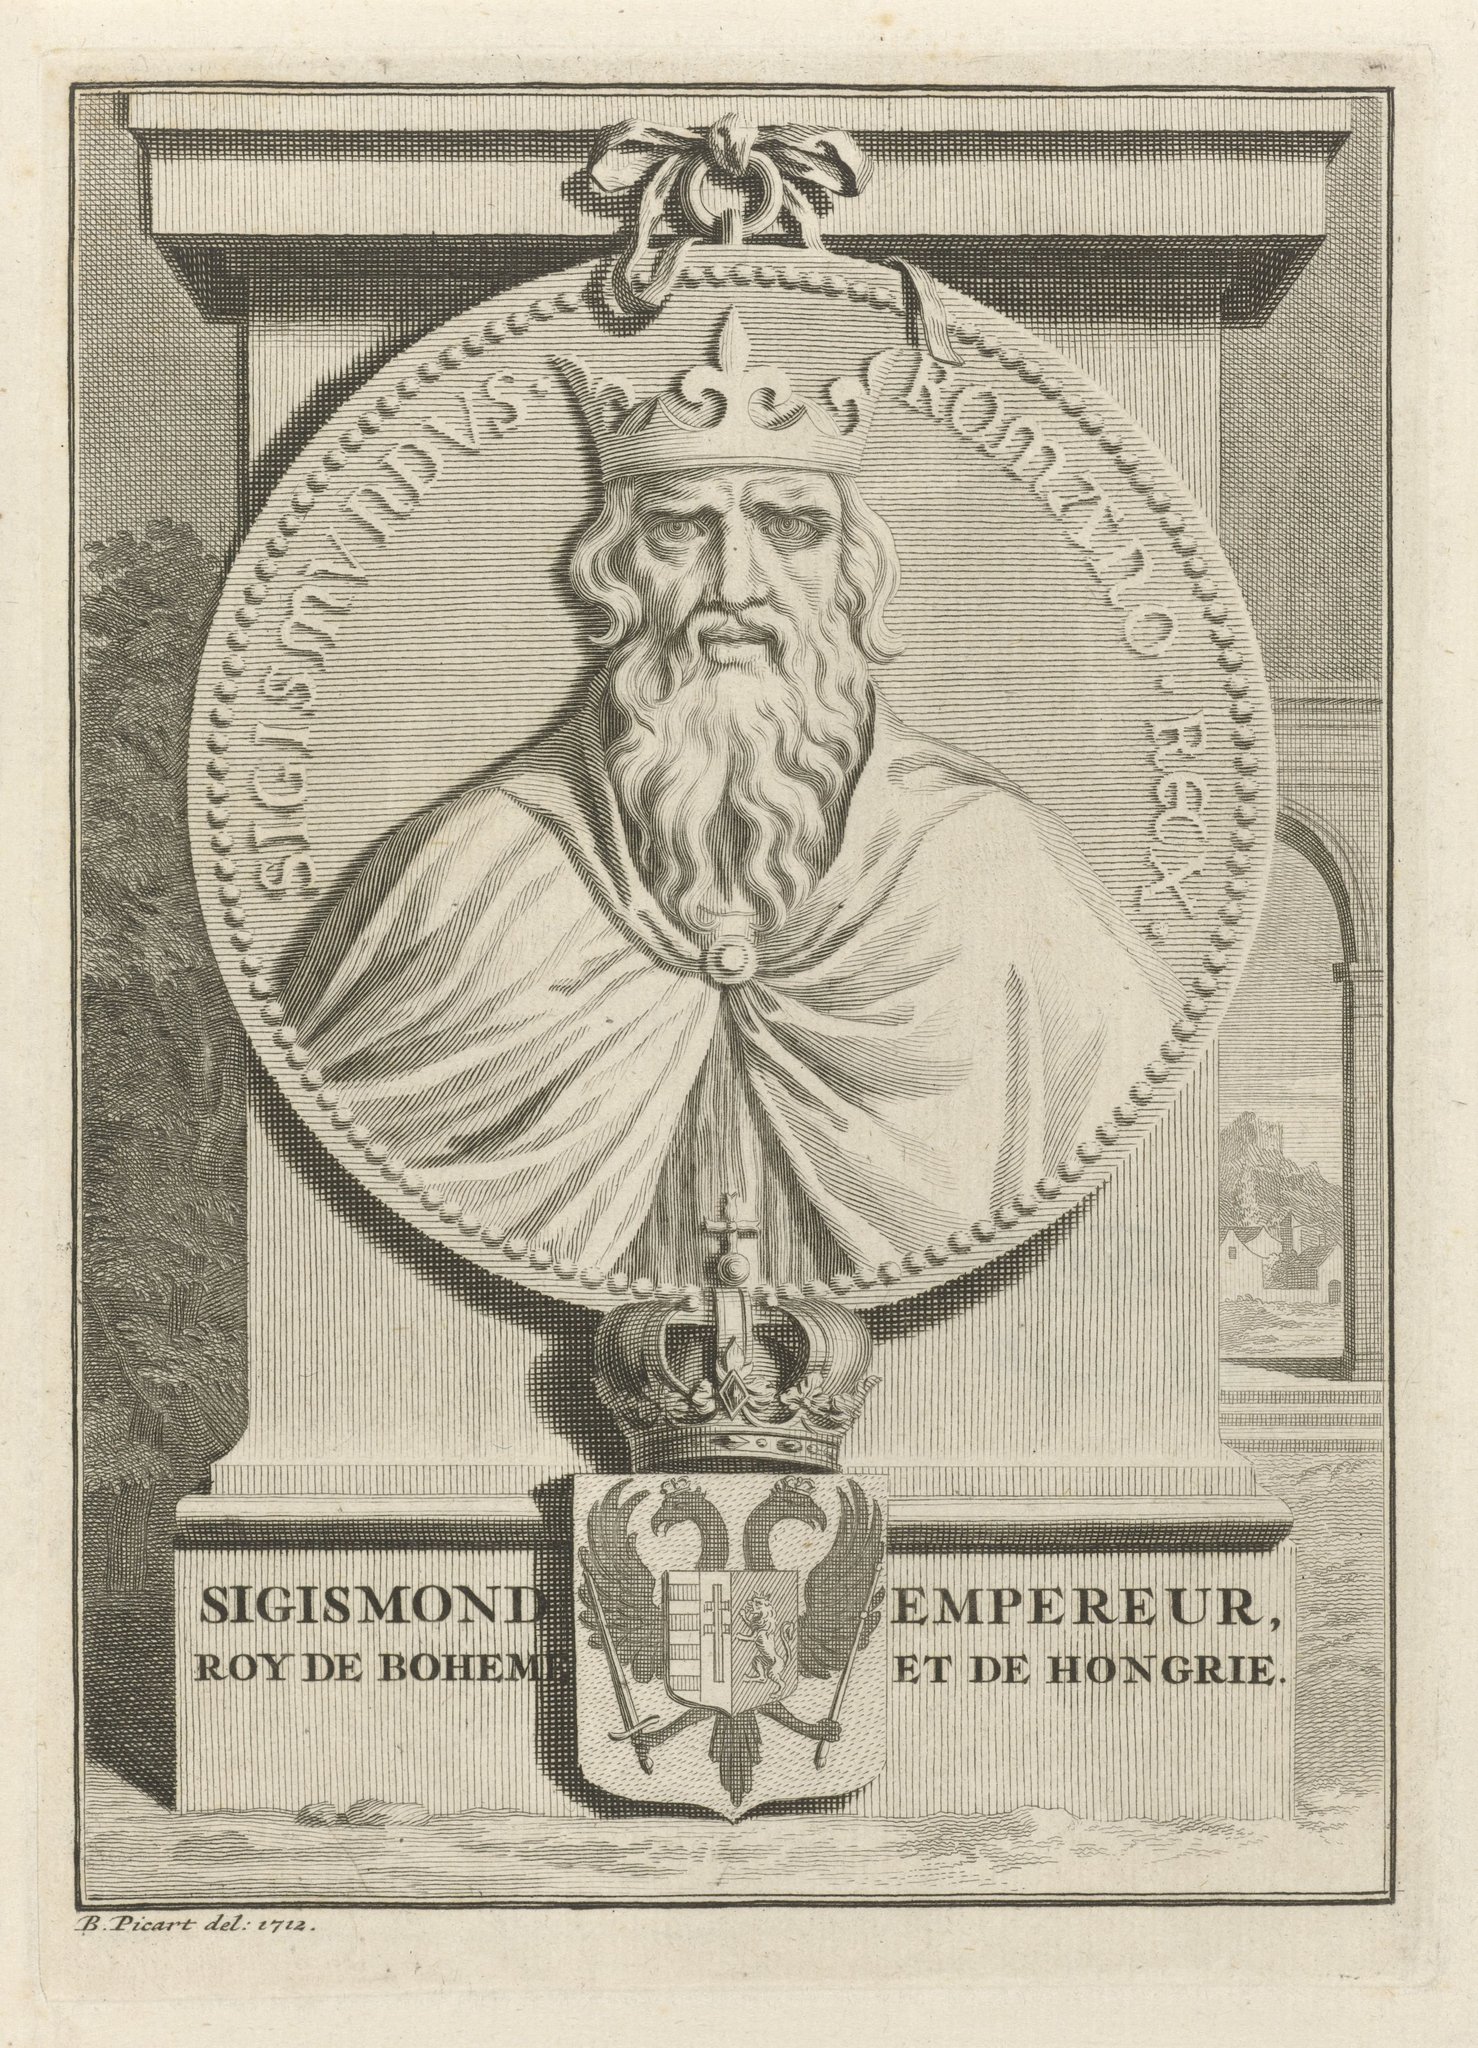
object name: print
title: Penning met het portret van Sigismund I, koning van Bohemen en Hongarije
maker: bernard picart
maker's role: draughtsman, print maker, publisher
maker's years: 1673-1733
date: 1712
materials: paper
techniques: engraving, etching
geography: amsterdam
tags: coat of arms (symbol of sovereignty)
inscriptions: collector's mark: Lugt 2228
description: Prent ook gebruikt als illustratie in: Lenfant, Jacques. Histoire du Concile de Constance. Parijs: Pierre Humbert, 1727.